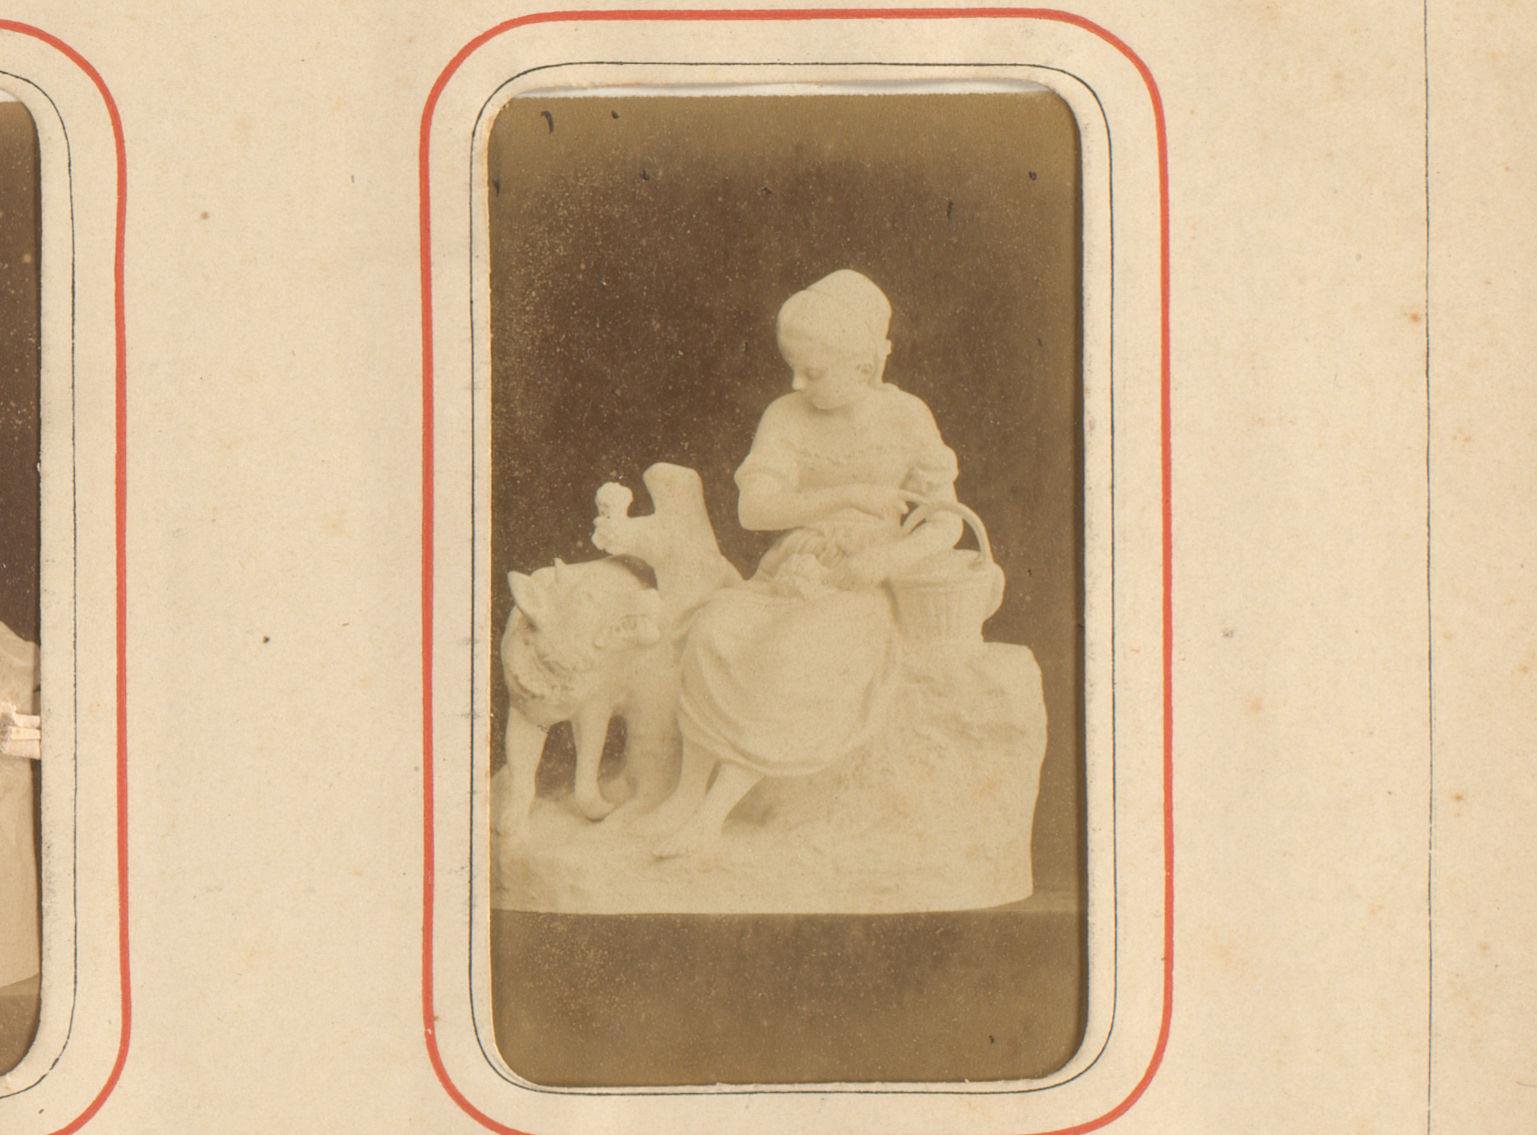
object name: reproduction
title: Rothkäppchen, nach Cauer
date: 1870-1890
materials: cardboard, paper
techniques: albumen print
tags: sculpture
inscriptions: number: ‘465.’